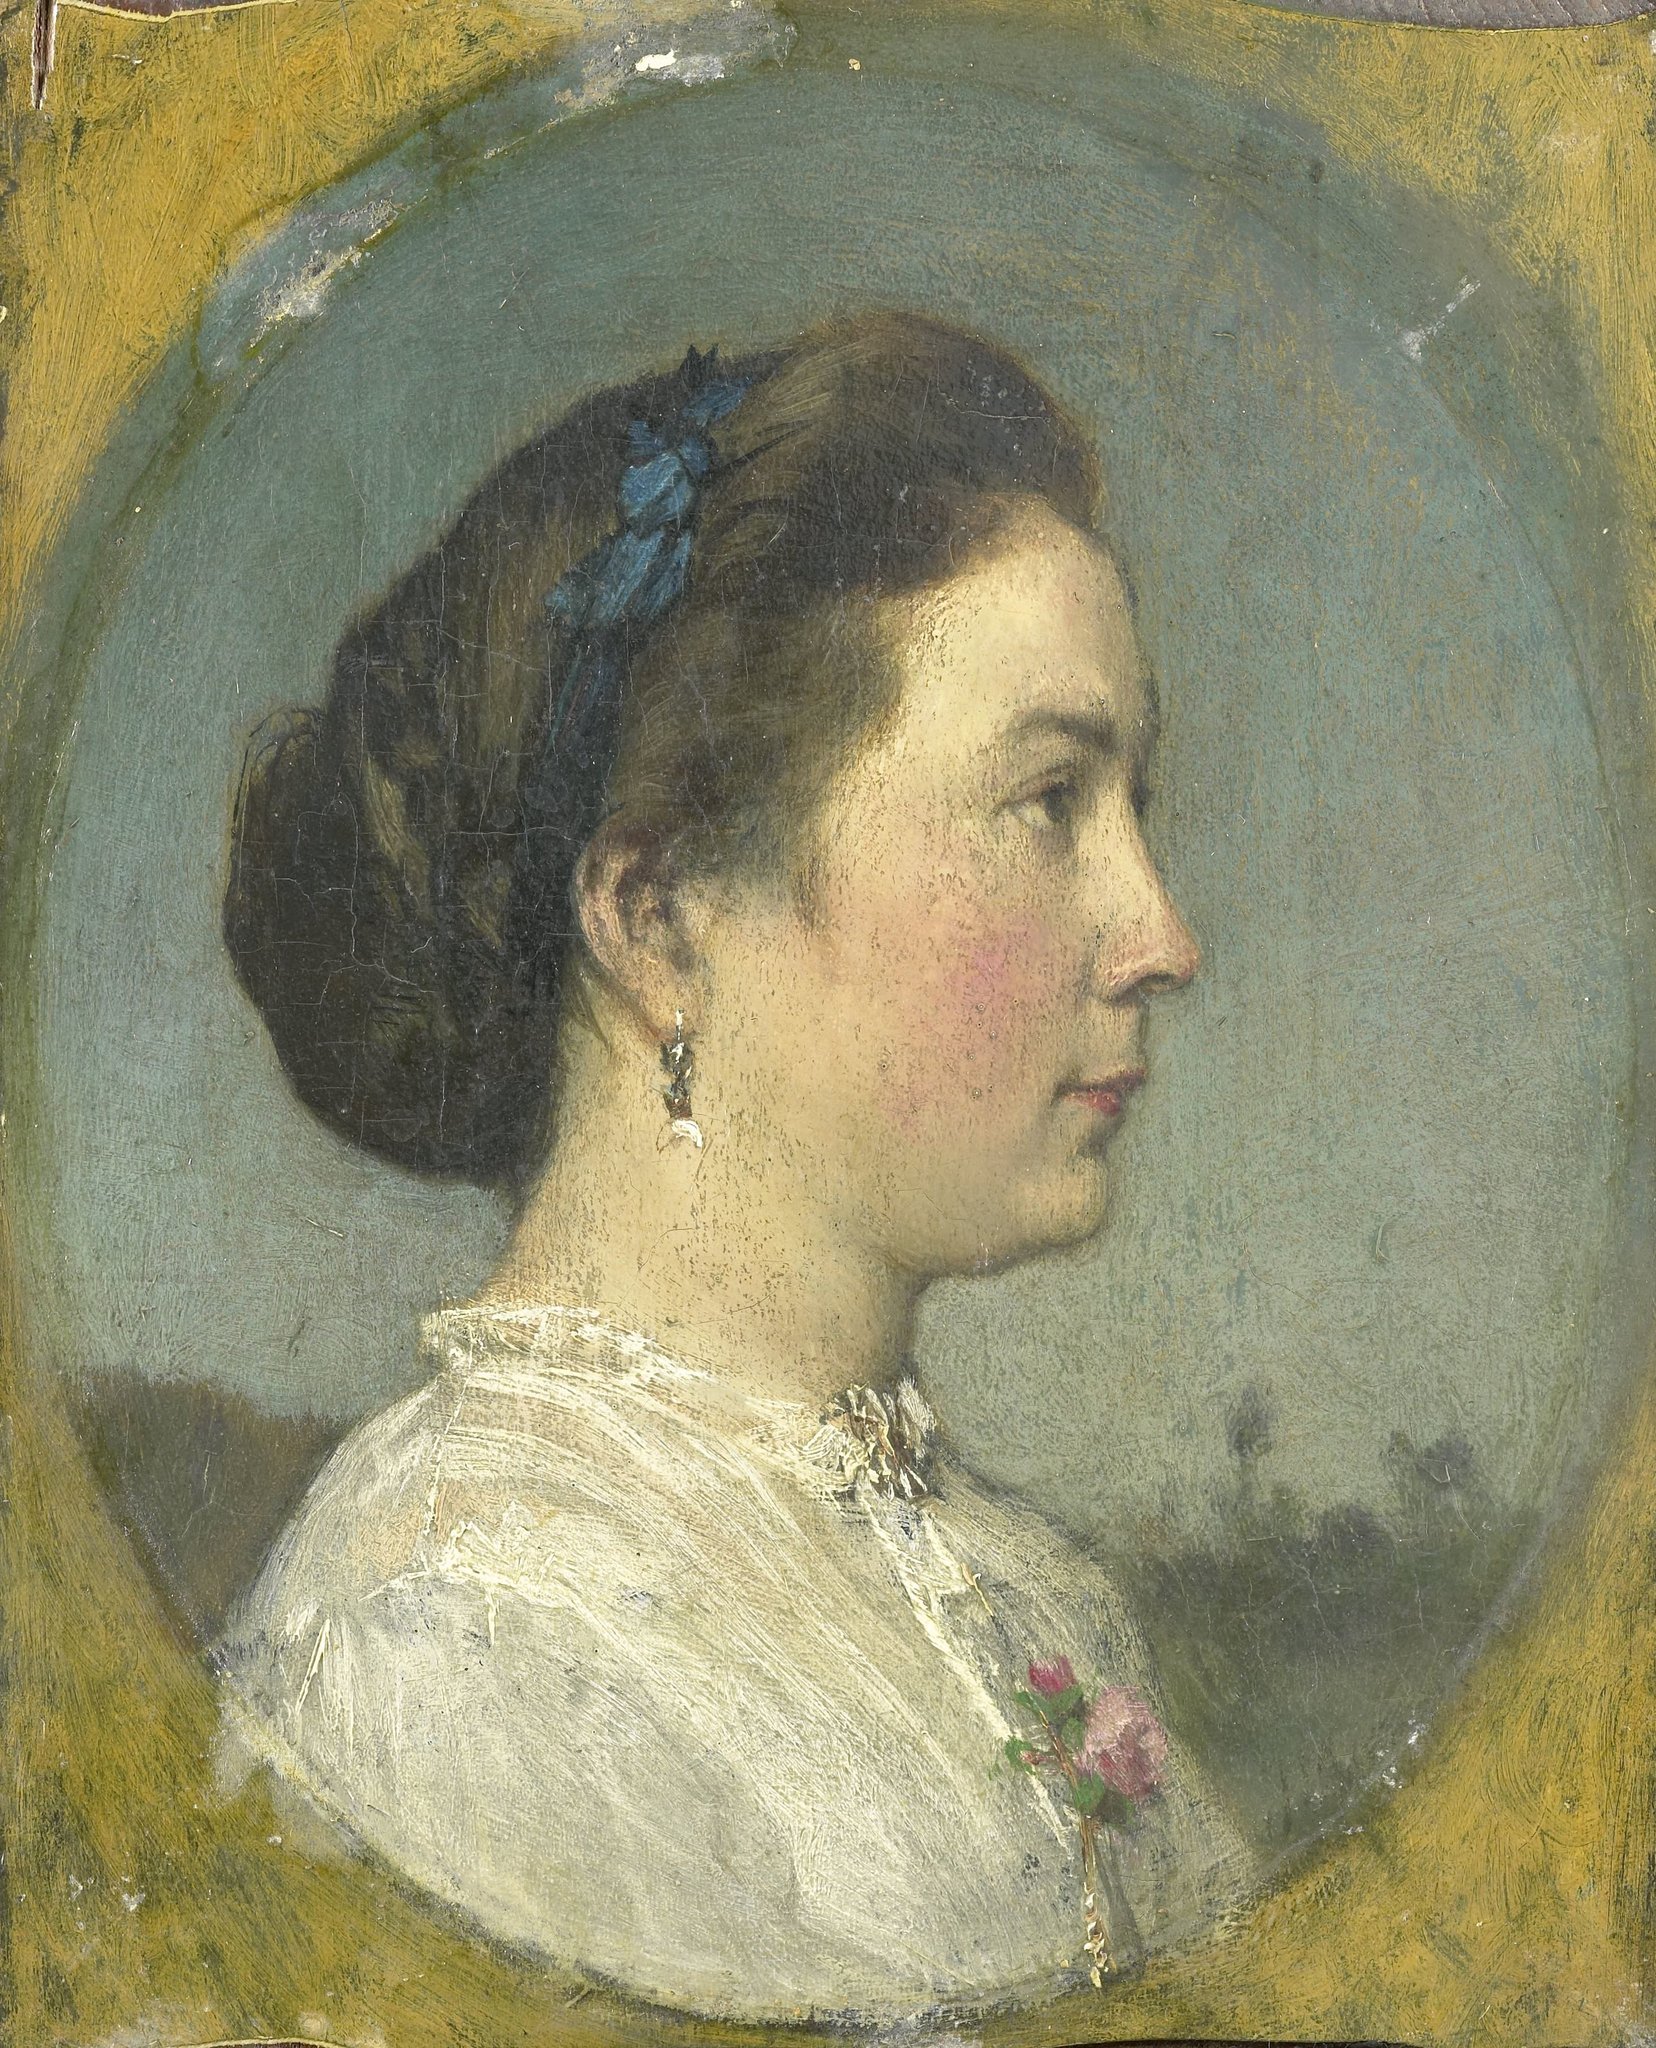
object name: painting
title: Portrait of Catharina Hendrika Horn, the Artist's Wife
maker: jacob maris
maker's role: draughtsman, painter, print maker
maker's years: 1837-1899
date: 1867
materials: oil, panel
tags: catharina hendrika maris-horn, historical persons - bb - woman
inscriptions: signature: ‘J.M.’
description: Portret van Catharina Hendrika Horn, sedert 1867 echtgenote van de schilder. Buste in ovaal, en profiil naar rechts.